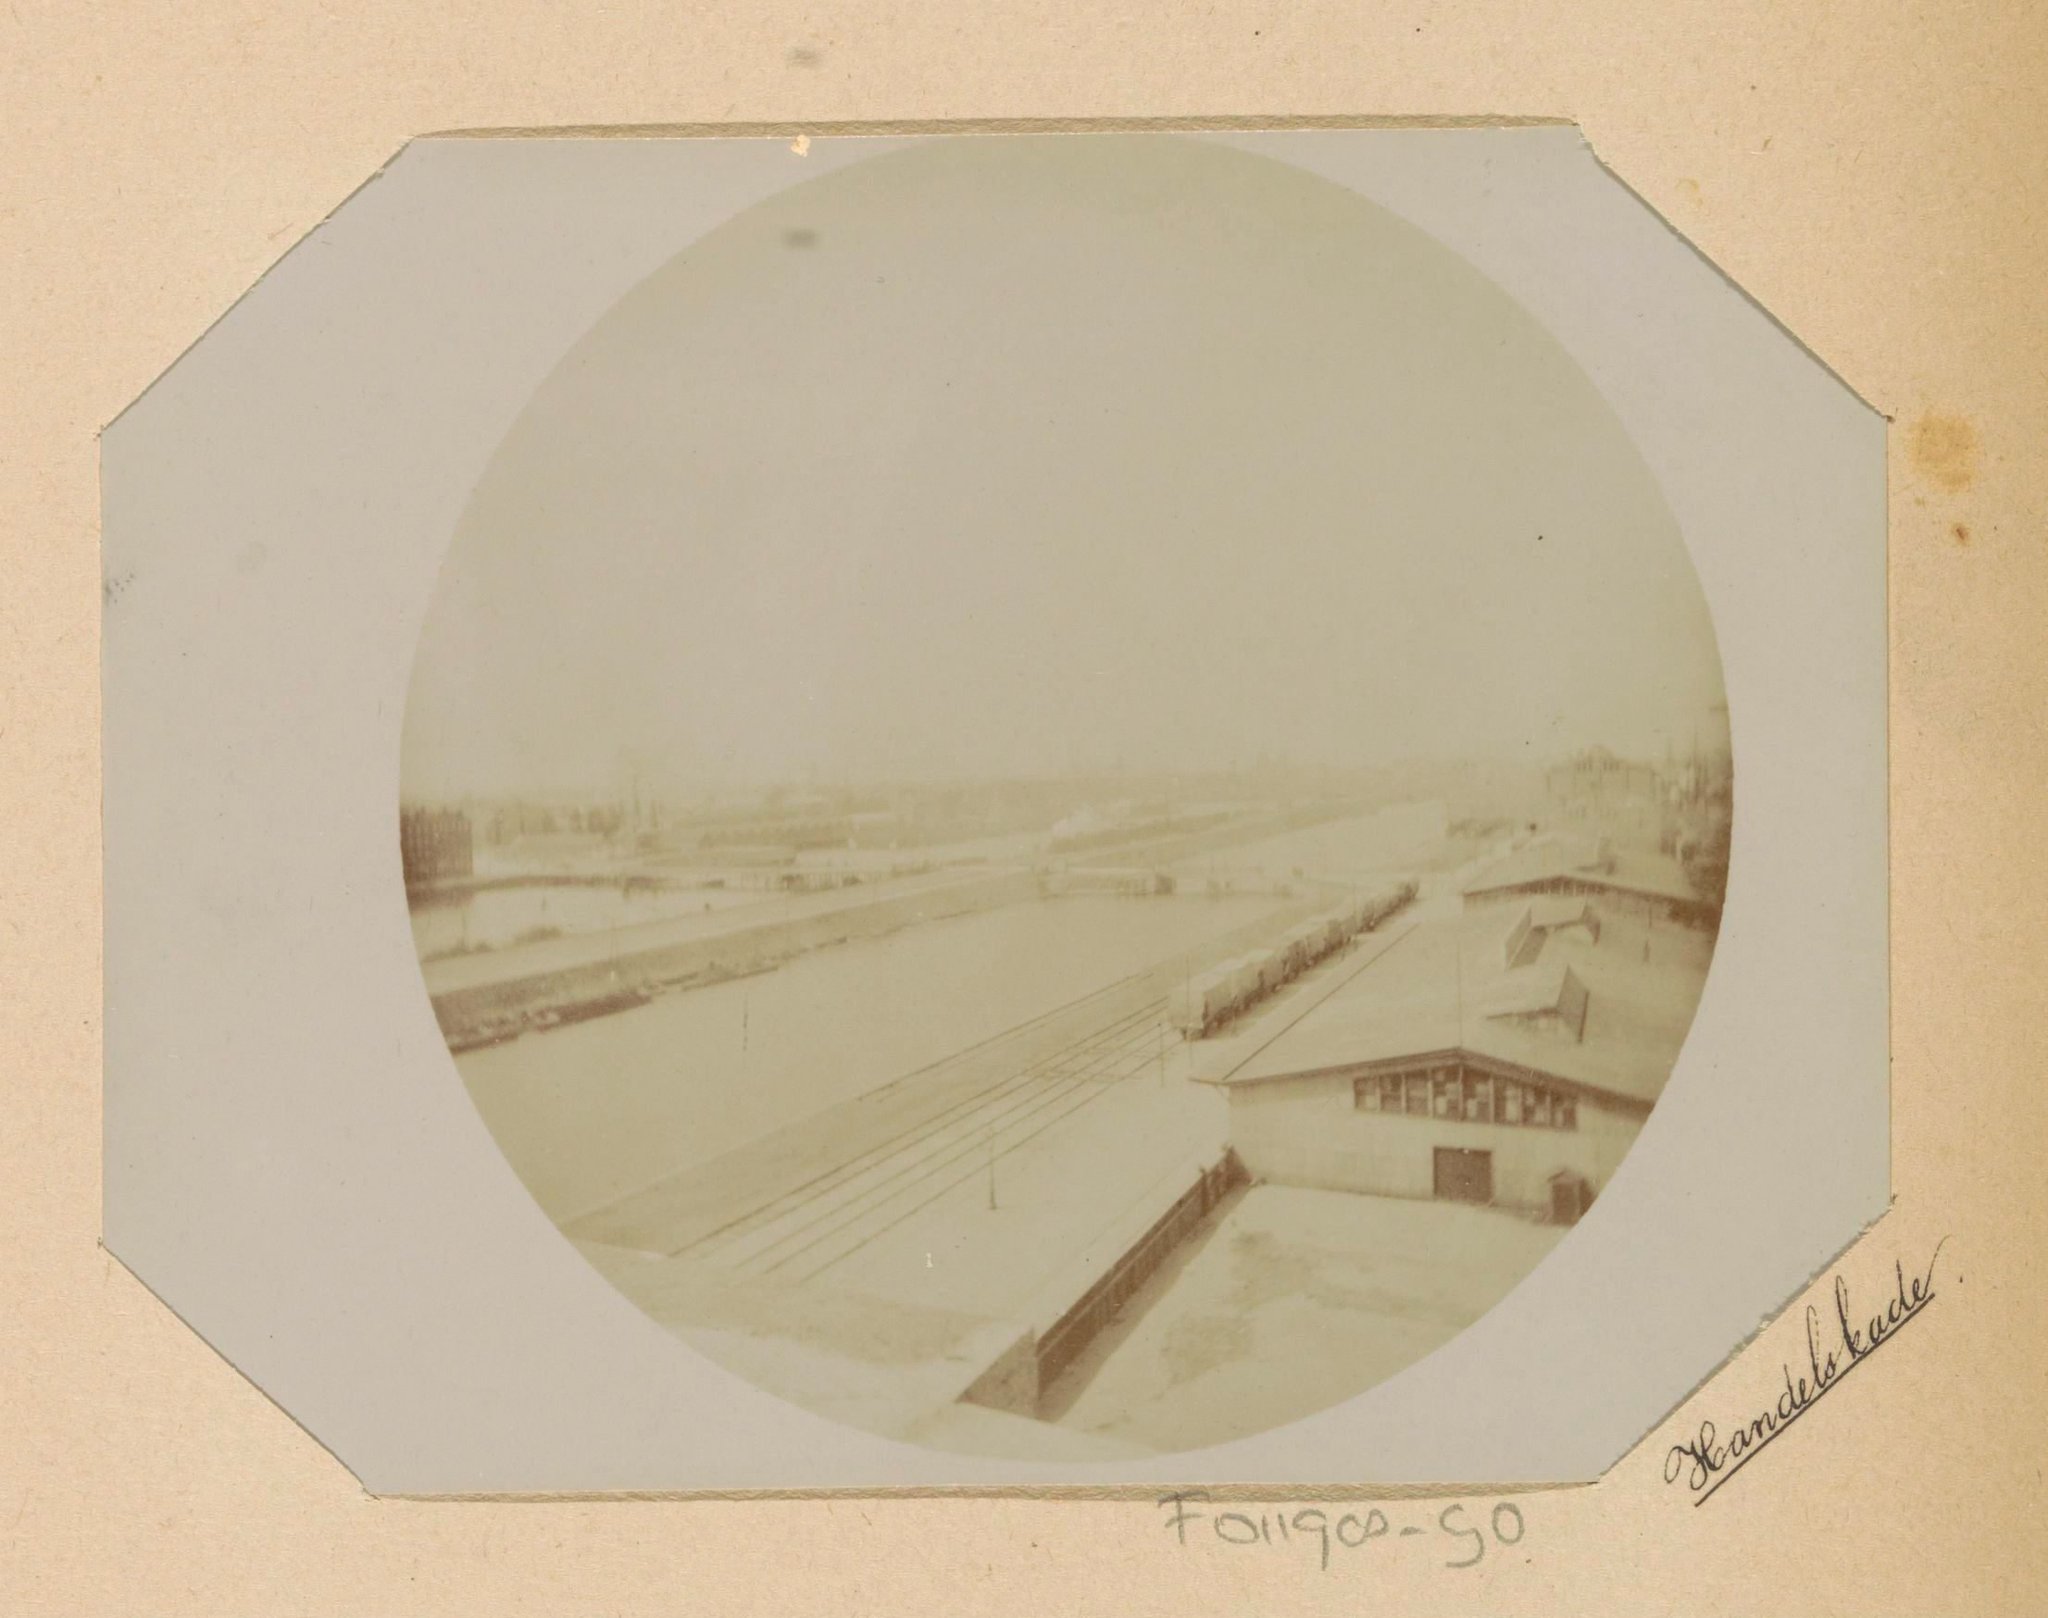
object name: photograph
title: Gezicht op de Oostelijke Handelskade aan het IJ in Amsterdam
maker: willem frederik piek jr.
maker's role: fotograaf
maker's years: 1874-1954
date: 1889-1893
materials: paper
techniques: gelatin silver print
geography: amsterdam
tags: harbour